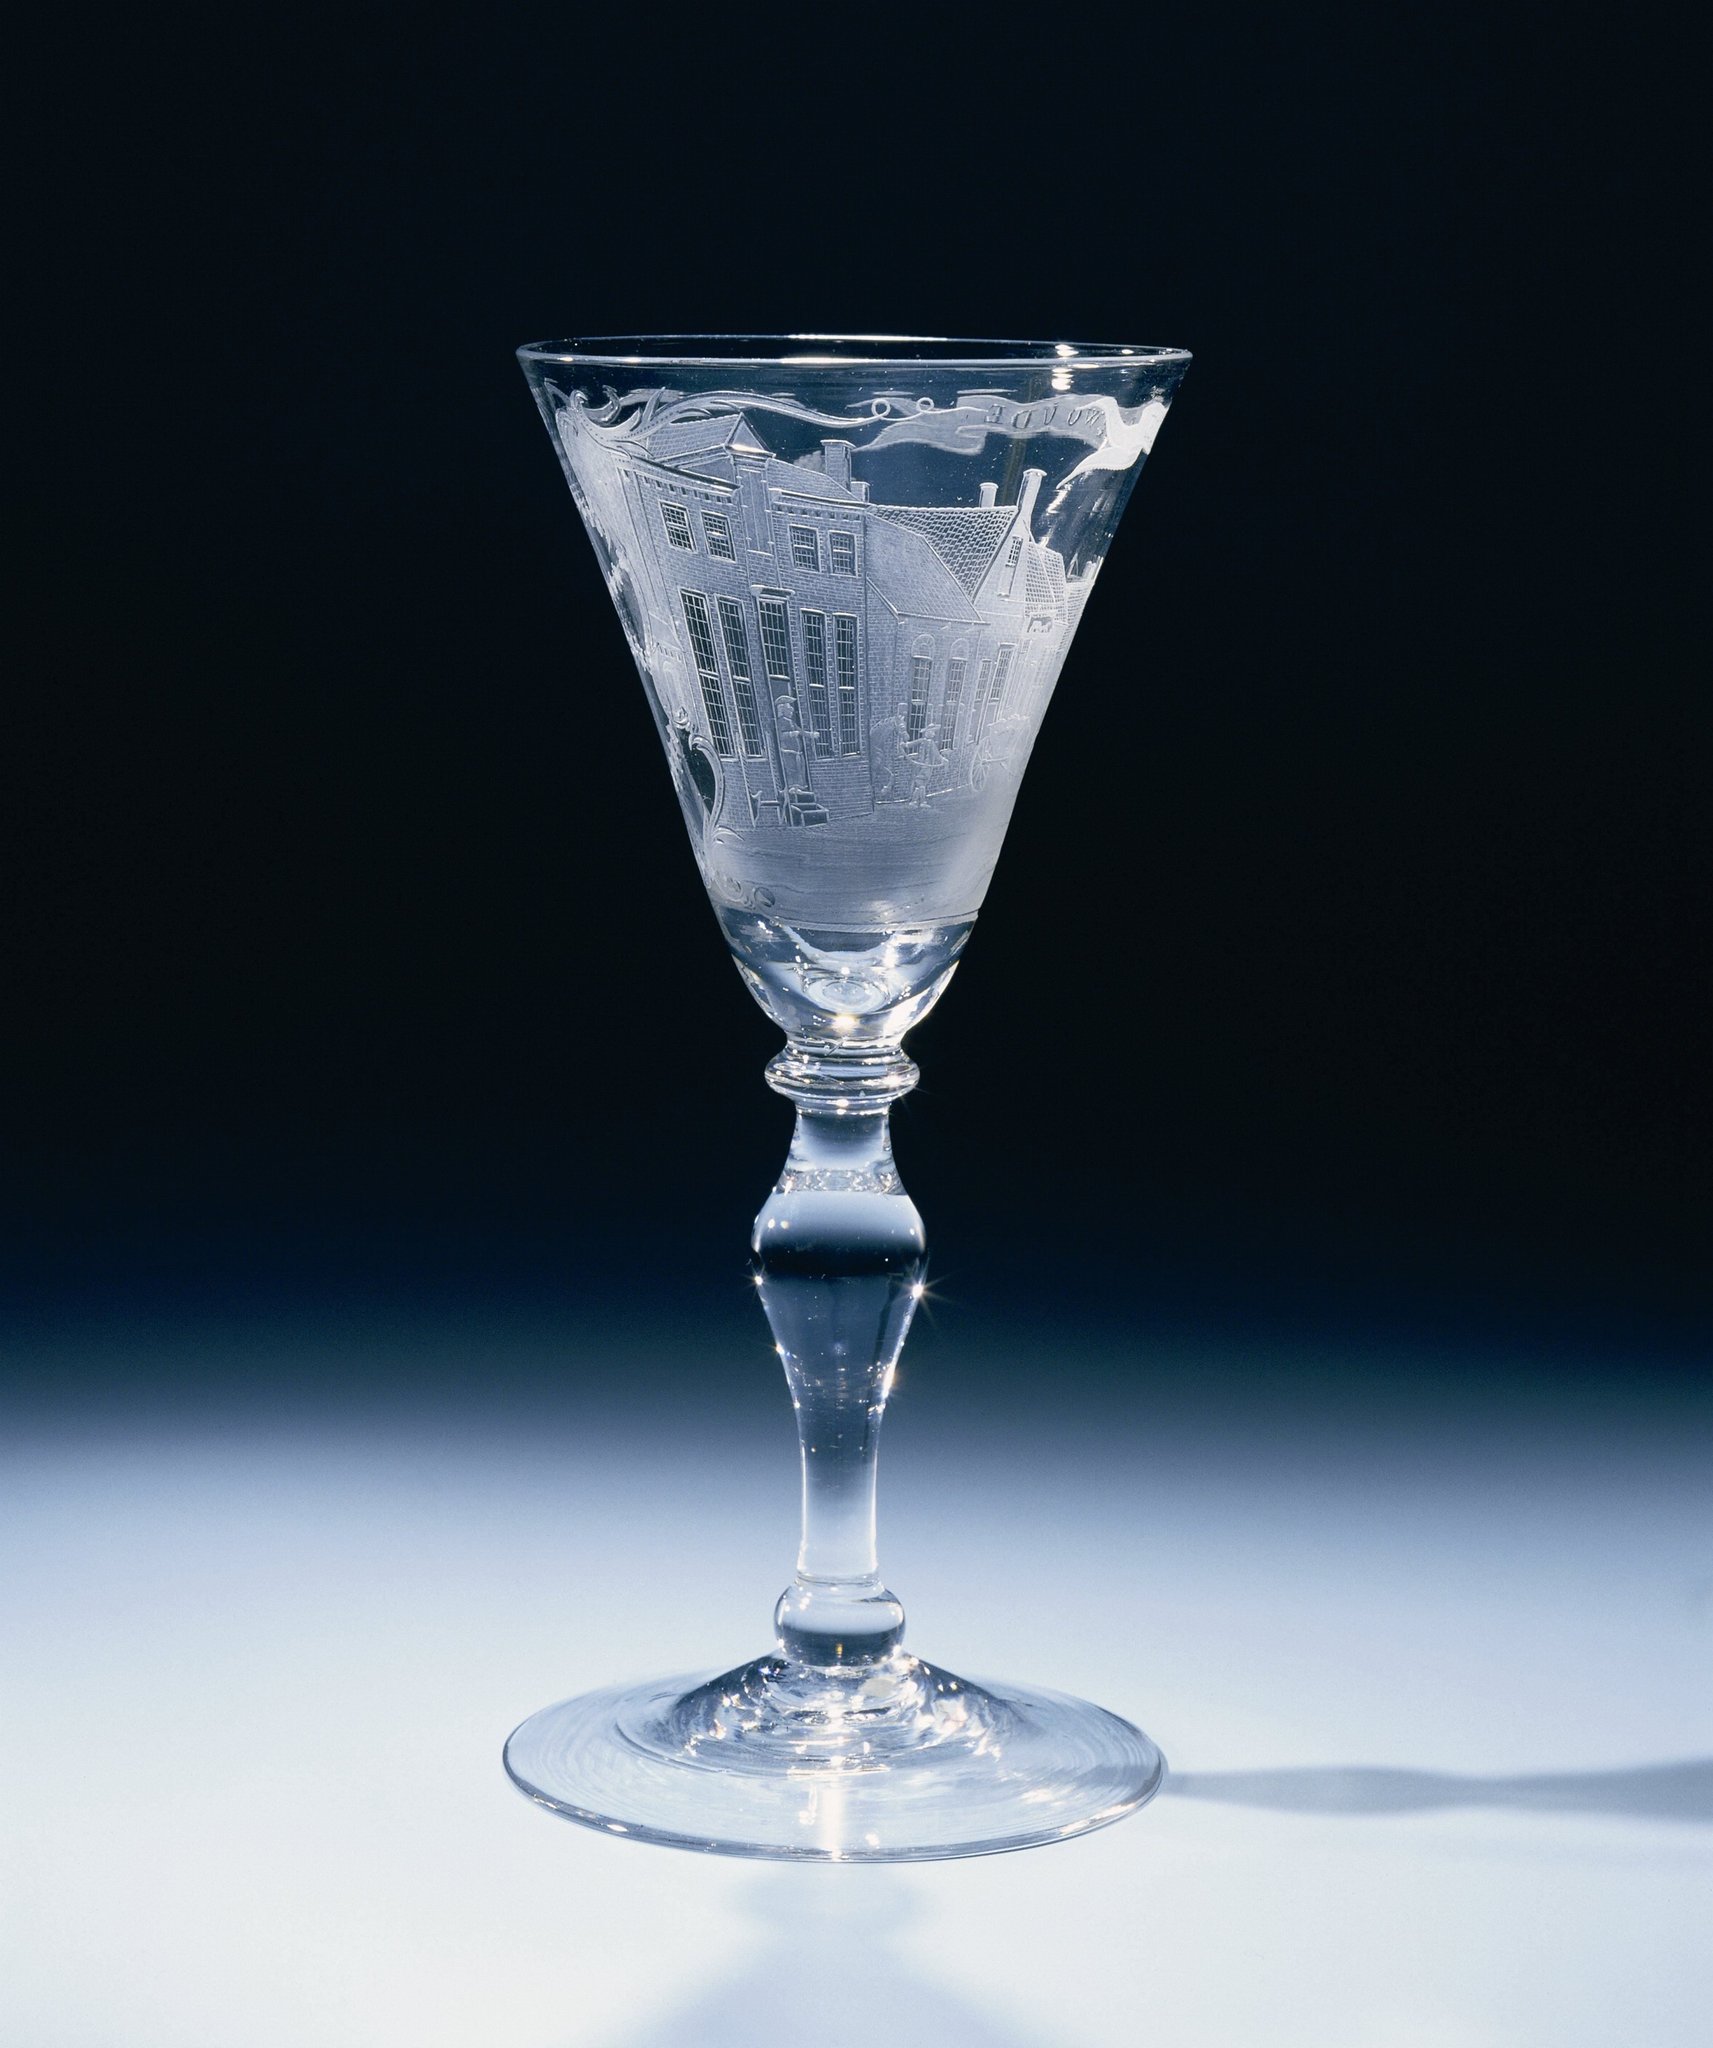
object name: goblet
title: Wine glass with a view of Rijnsaterwoude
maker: Anonymous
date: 1768-1769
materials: glass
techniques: glassblowing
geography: northern netherlands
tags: urban housing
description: inscription: ‘Rynsaterwoude’